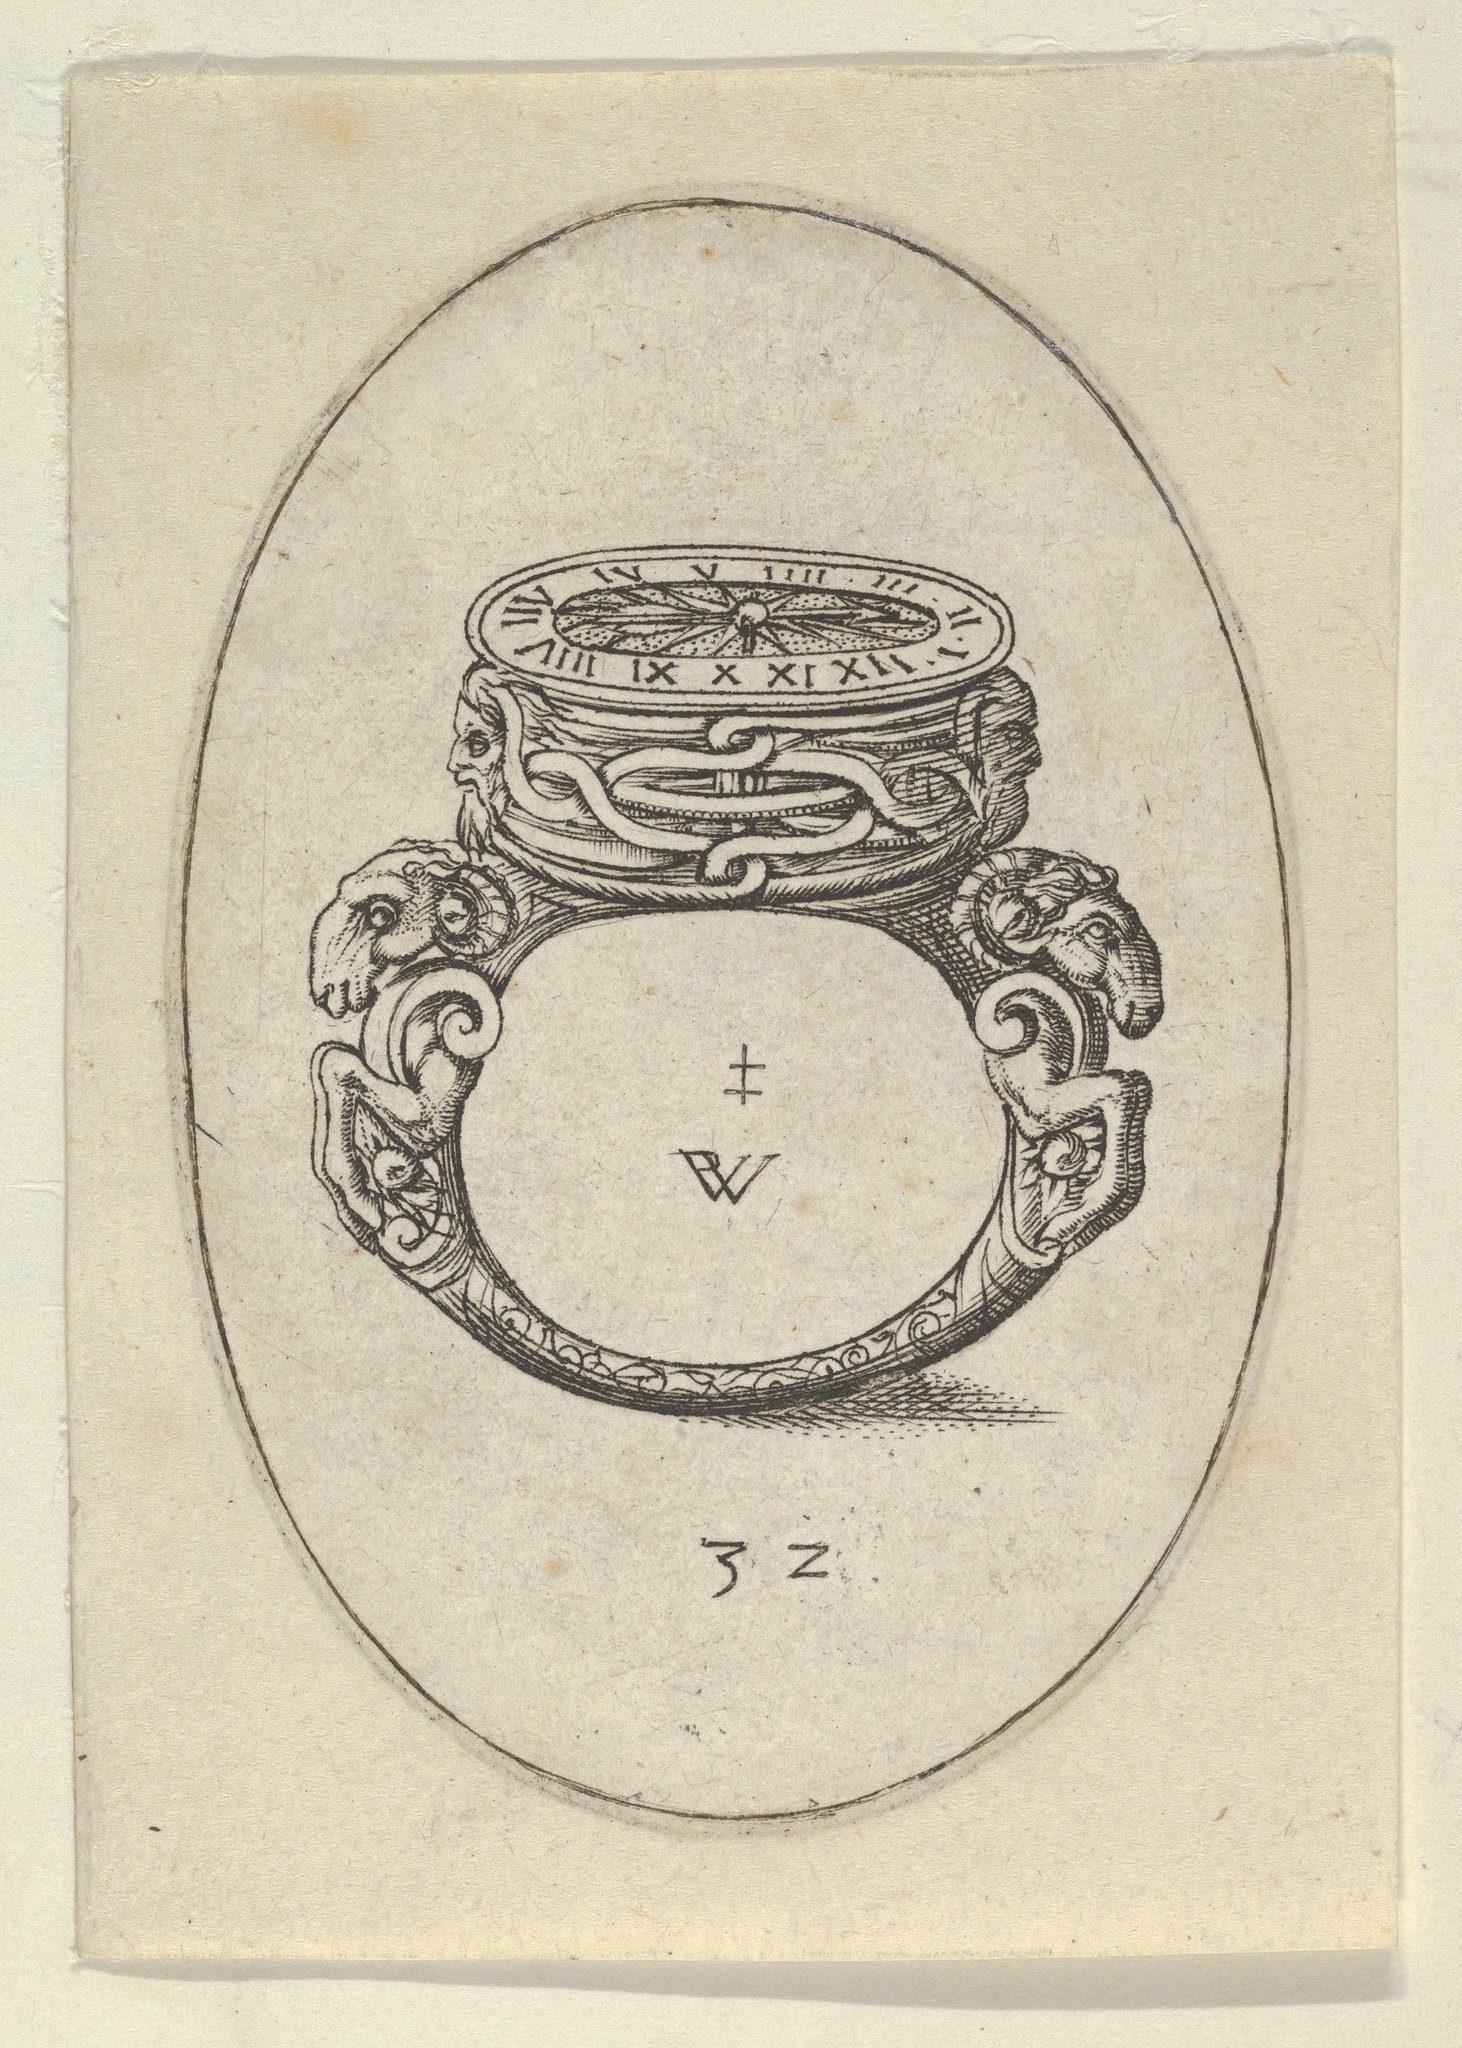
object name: print ornament architecture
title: Design for a Ring Watch, Plate 32 from Livre d'Aneaux d'Orfevrerie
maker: pierre woeiriot de bouzey ii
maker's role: artist and engraver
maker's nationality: french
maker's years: 1532-1599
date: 1561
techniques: engraving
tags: watches,rams